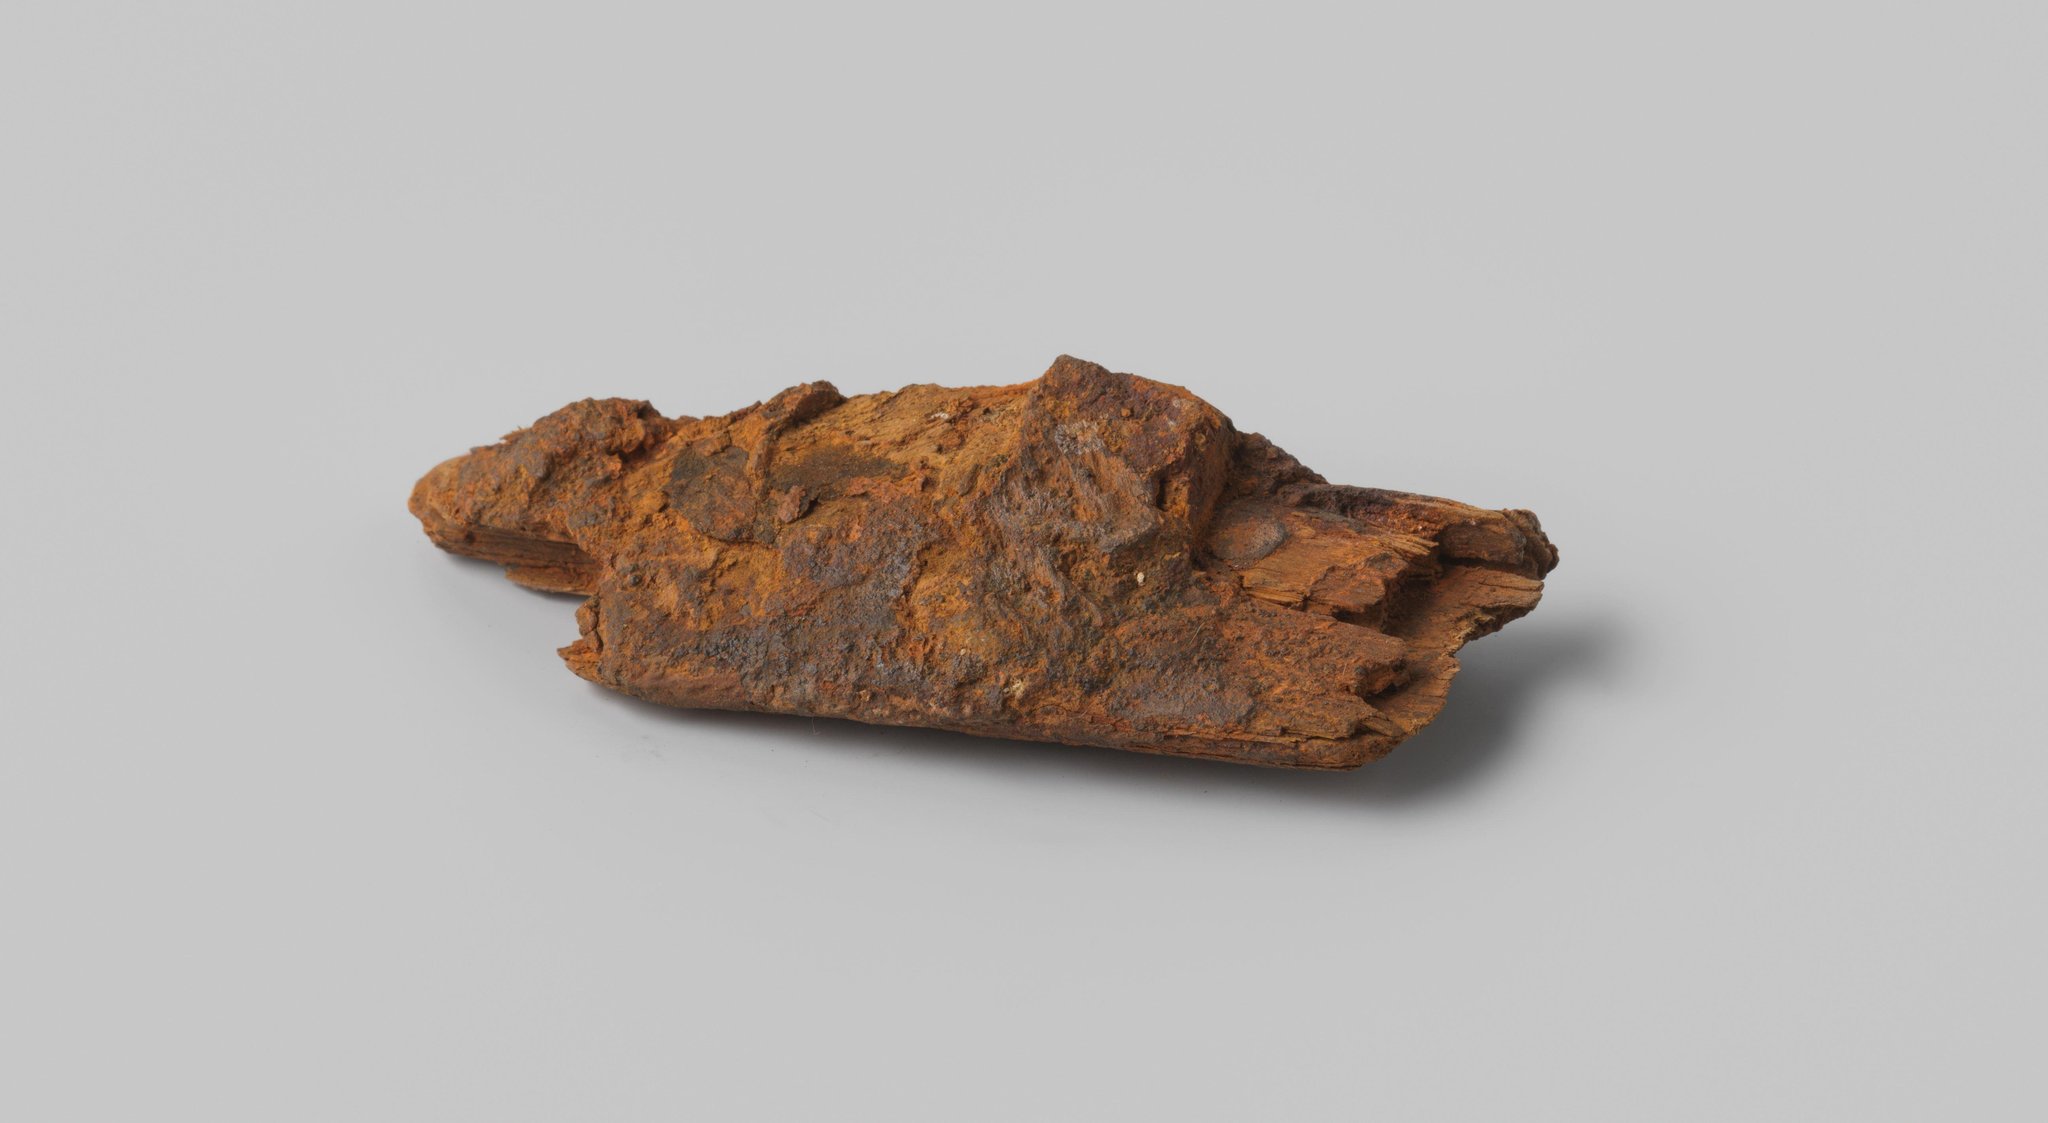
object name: knife with sheath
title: Fragment schede uit het wrak van de Oost-Indiëvaarder Hollandia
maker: Anonymous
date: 1700-1743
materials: leather, wood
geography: netherlands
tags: verenigde oostindische compagnie, hollandia (schip), annet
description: Fragm, id. NG 1980-27H1832, both ends broken.